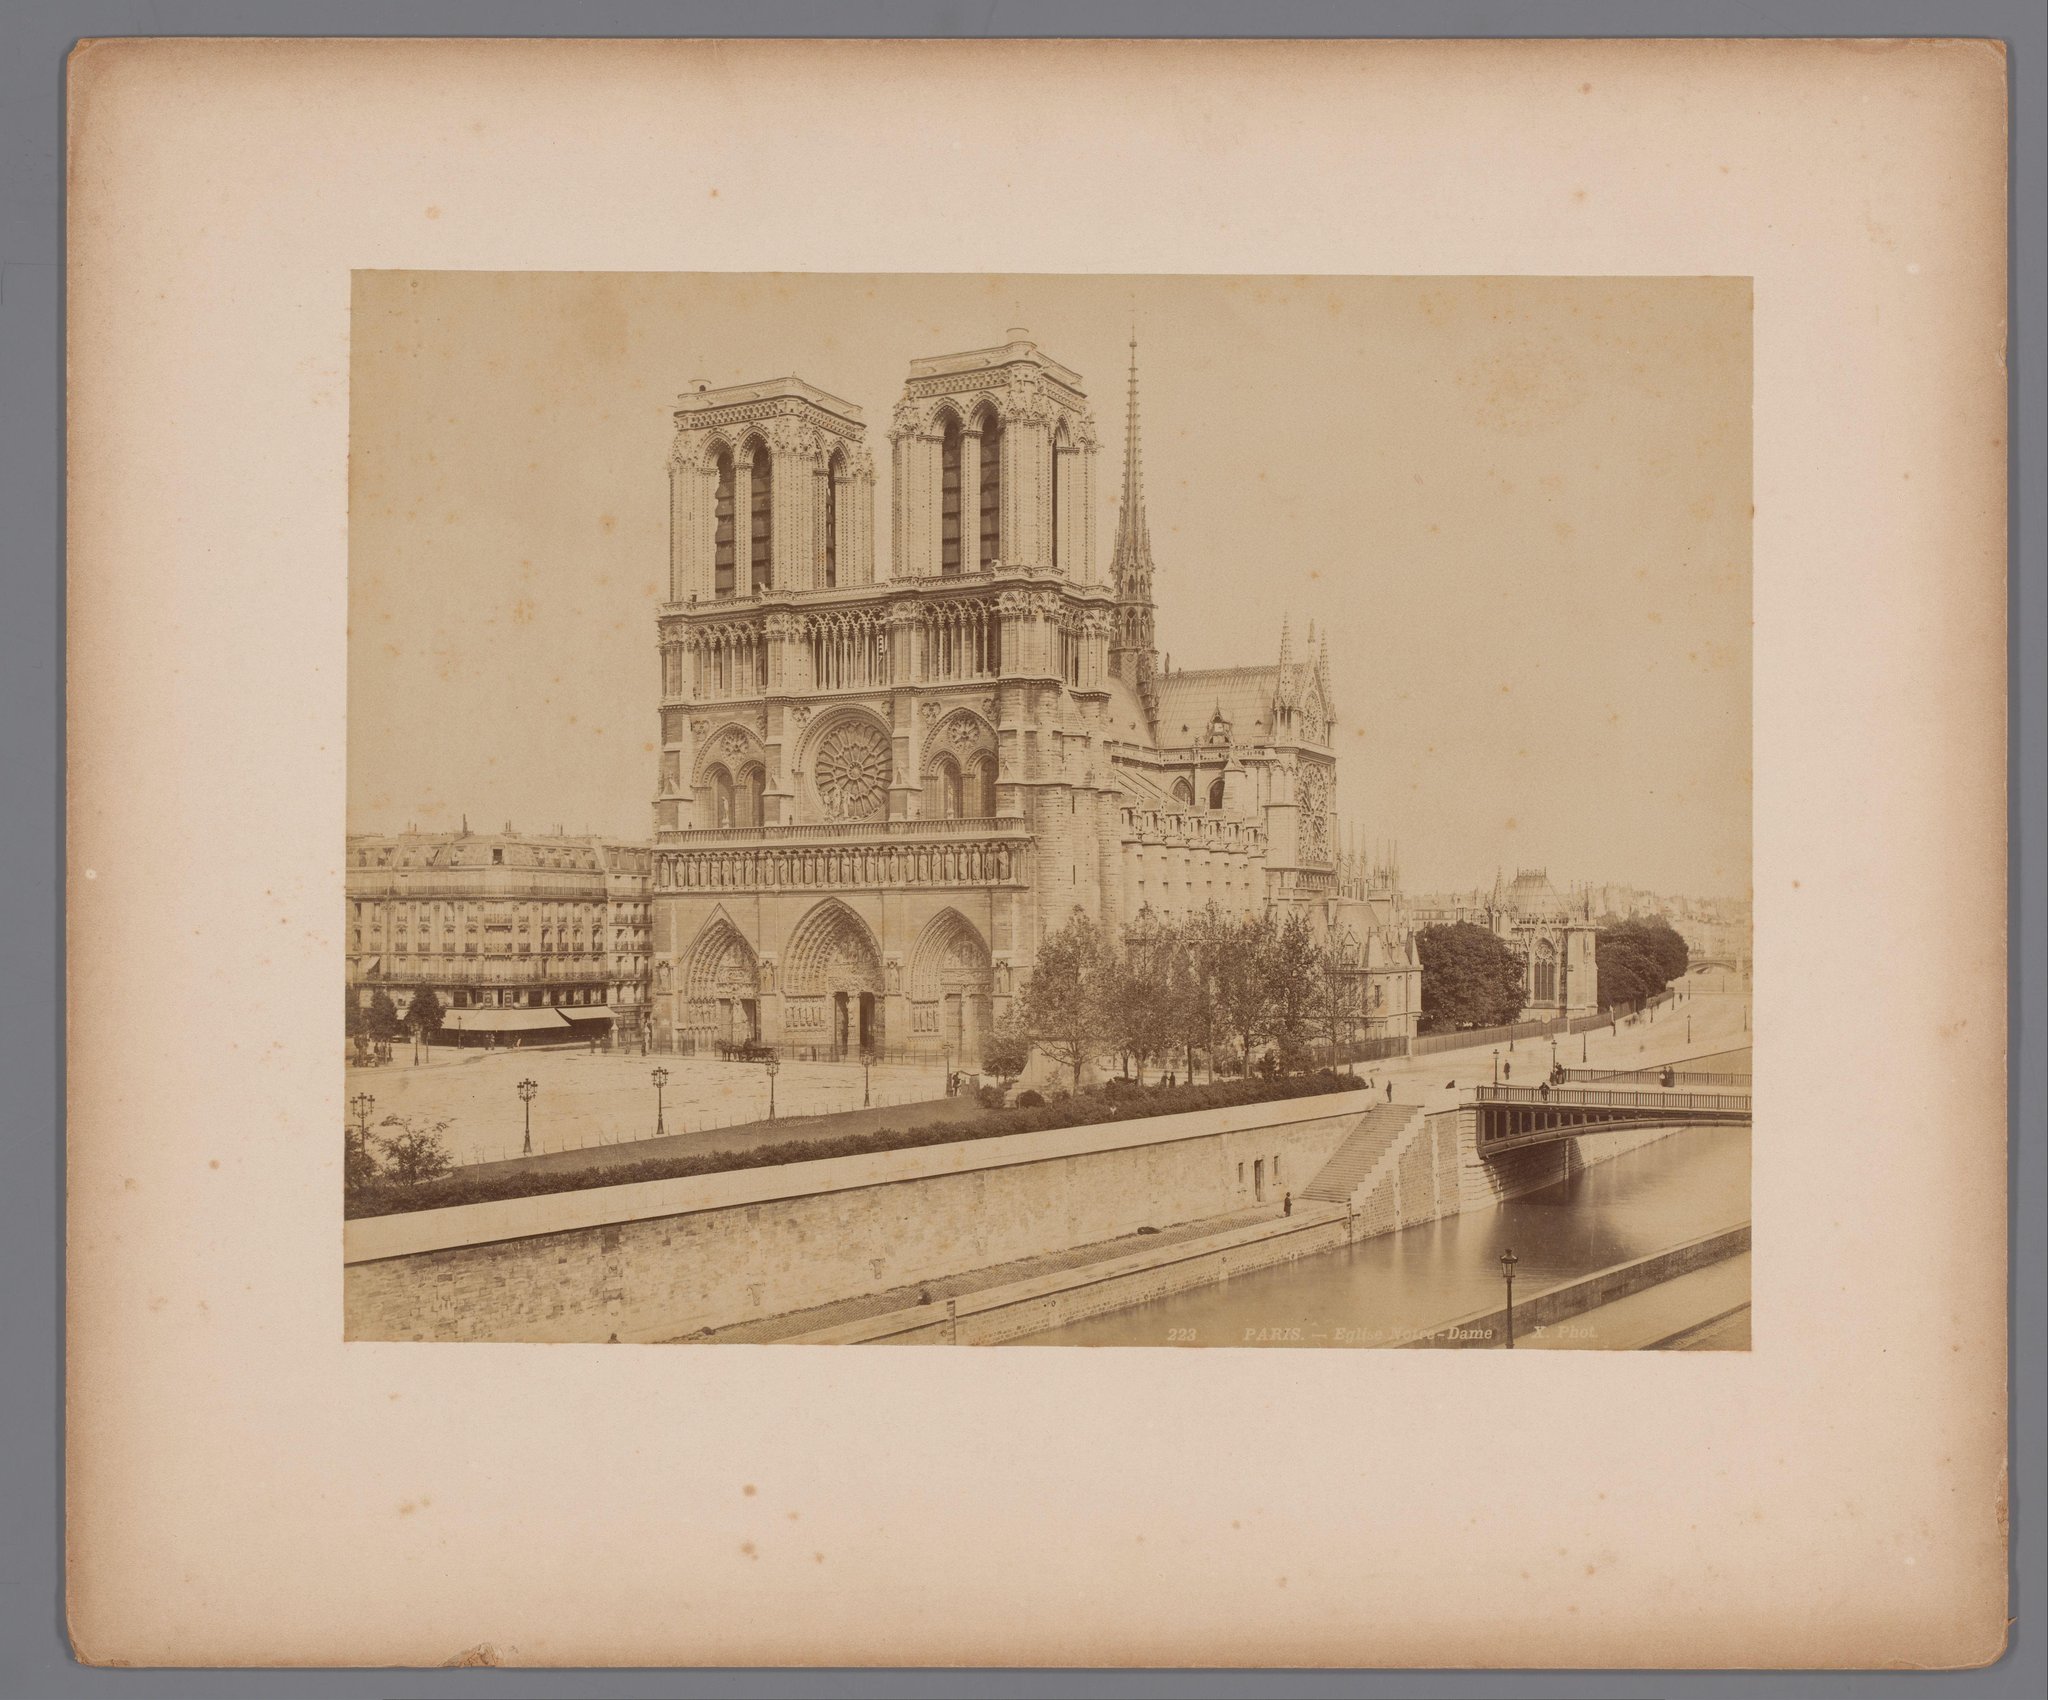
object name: photograph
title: Notre Dame, Parijs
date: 1870-1900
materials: cardboard, paper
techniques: albumen print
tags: notre-dame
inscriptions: inscription: ‘223. PARIS. - Eglise Notre-Dame’, signature: ‘X. Phot.’